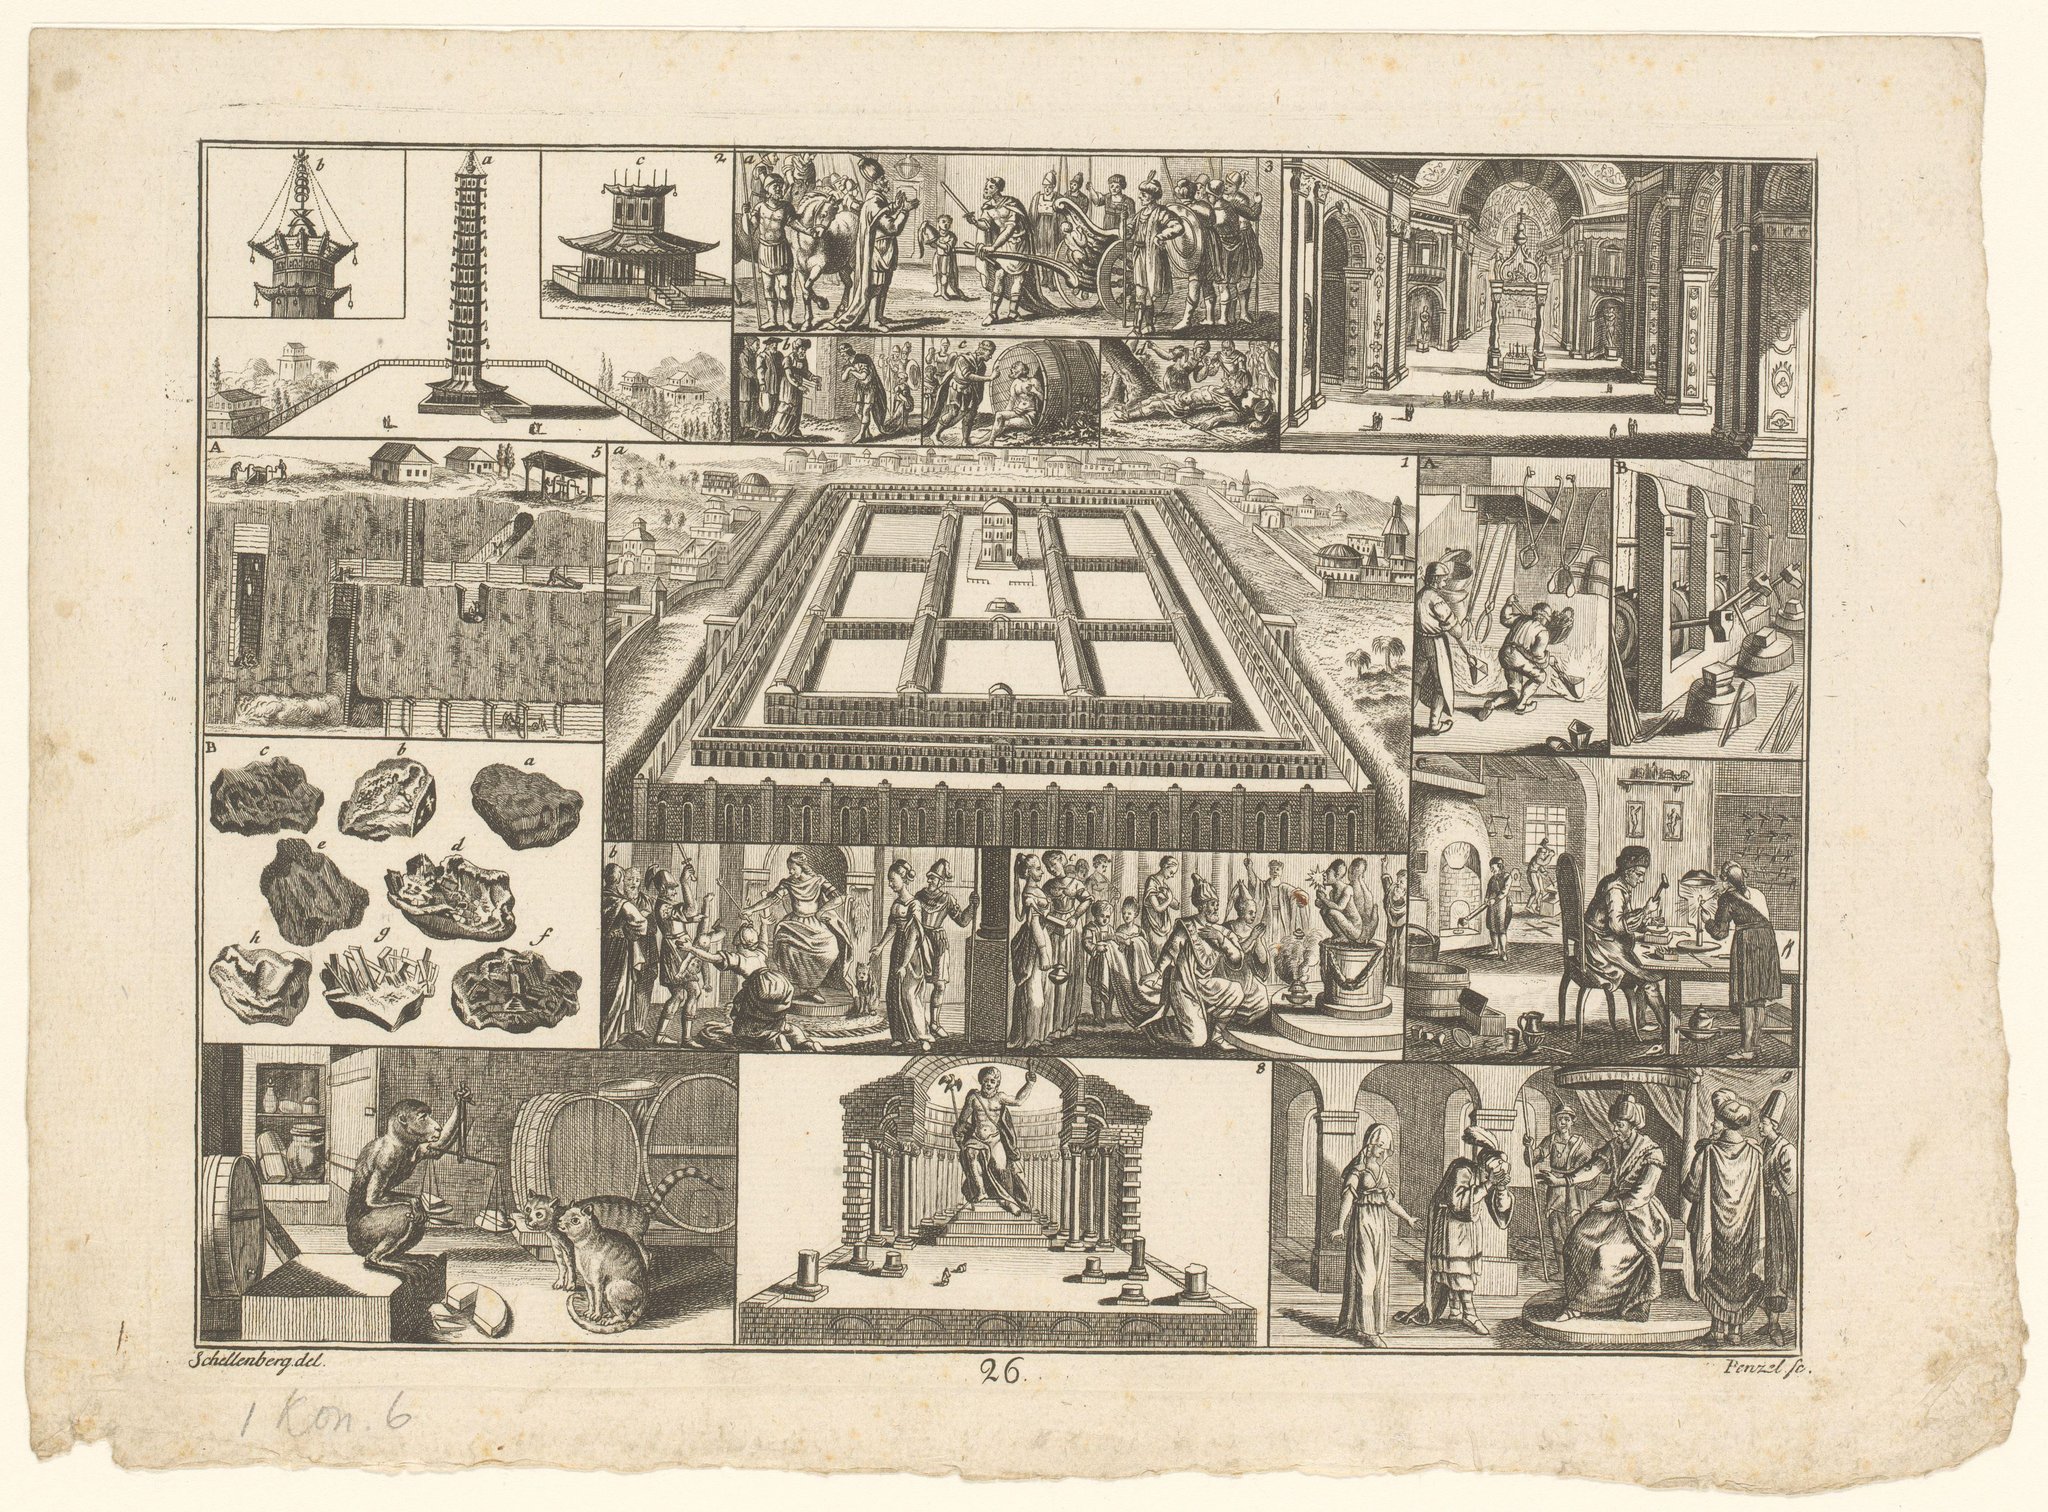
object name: print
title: Blad met uiteenlopende encyclopedische voorstellingen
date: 1784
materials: paper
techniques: engraving, etching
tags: temple of solomon (1 kings 5-9; 2 chronicles 2-7)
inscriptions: collector's mark: Lugt 2228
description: Maakt deel uit van een serie encyclopedische prenten door verschillende kunstenaars naar ontwerp van Daniel Nikolaus Chodowiecki bij Johann Sigmund Stoy's 'Bilder-Akademie für die Jugend', uitgegeven te Neurenberg in 1784. De prenten waren bedoeld voor kinderen om uit te knippen, op kaarten te plakken en vervolgens op logische wijze te rangschikken (zie Heesen, Anke te. The World in a Box: The Story of an Eighteenth-Century Picture Encyclopedia. Chicago: University of Chicago Press, 2002).